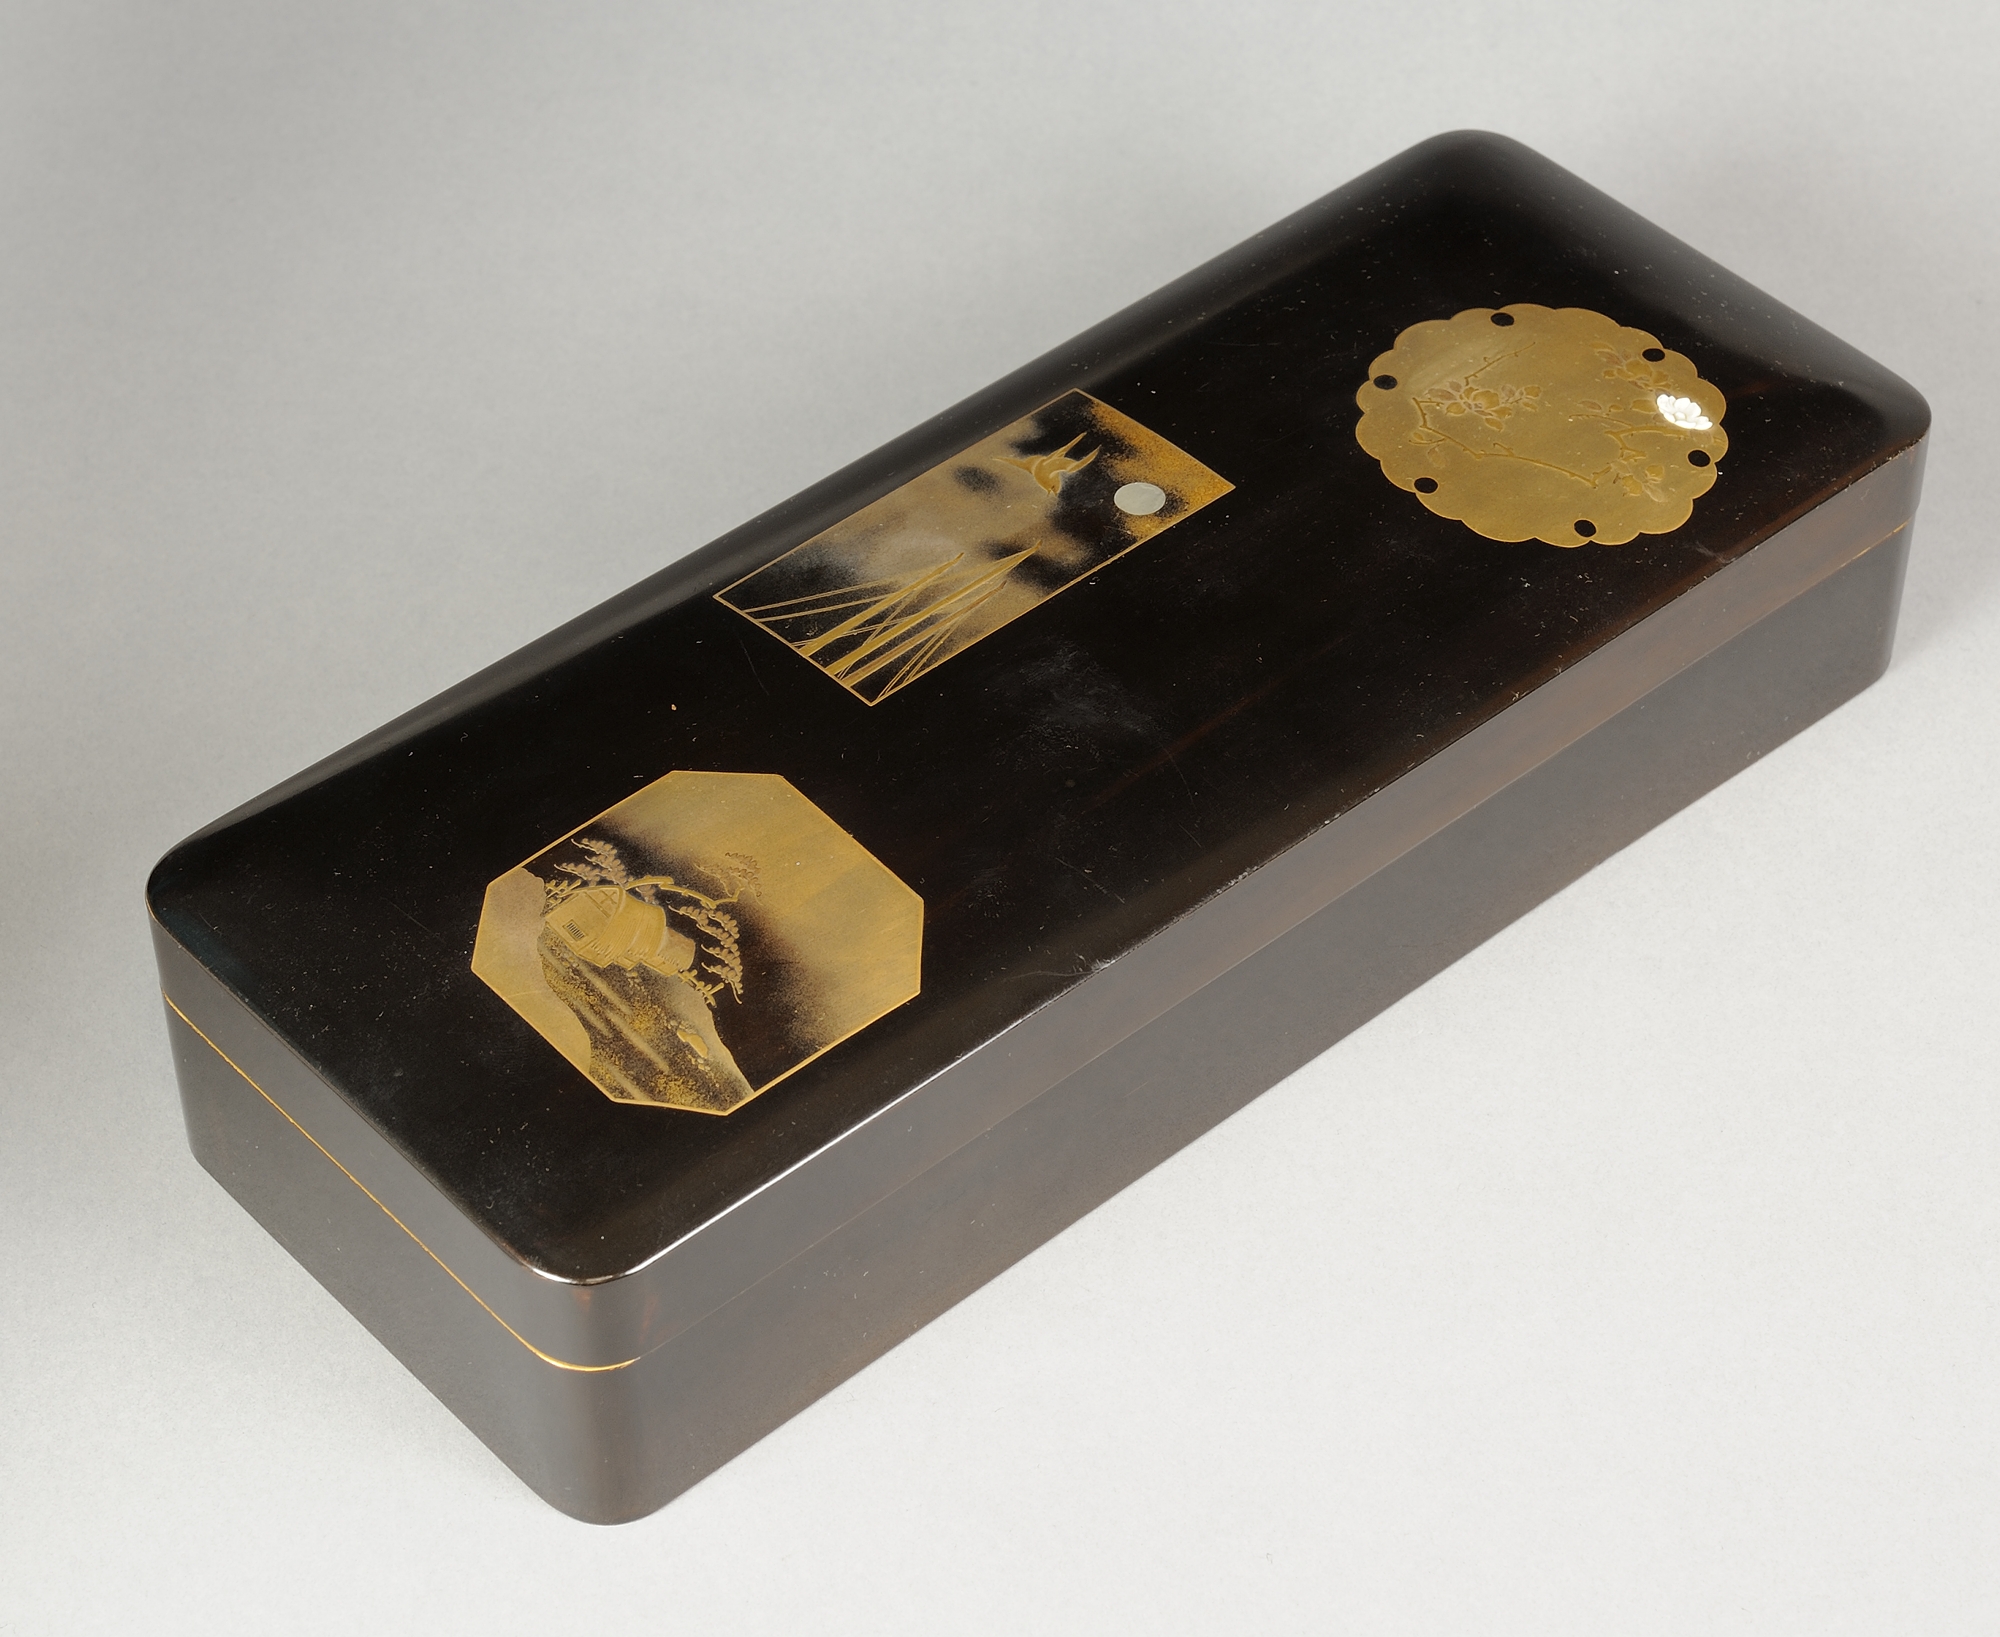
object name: letter box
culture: japanese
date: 1801-1900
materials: lacquer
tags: houses,trees